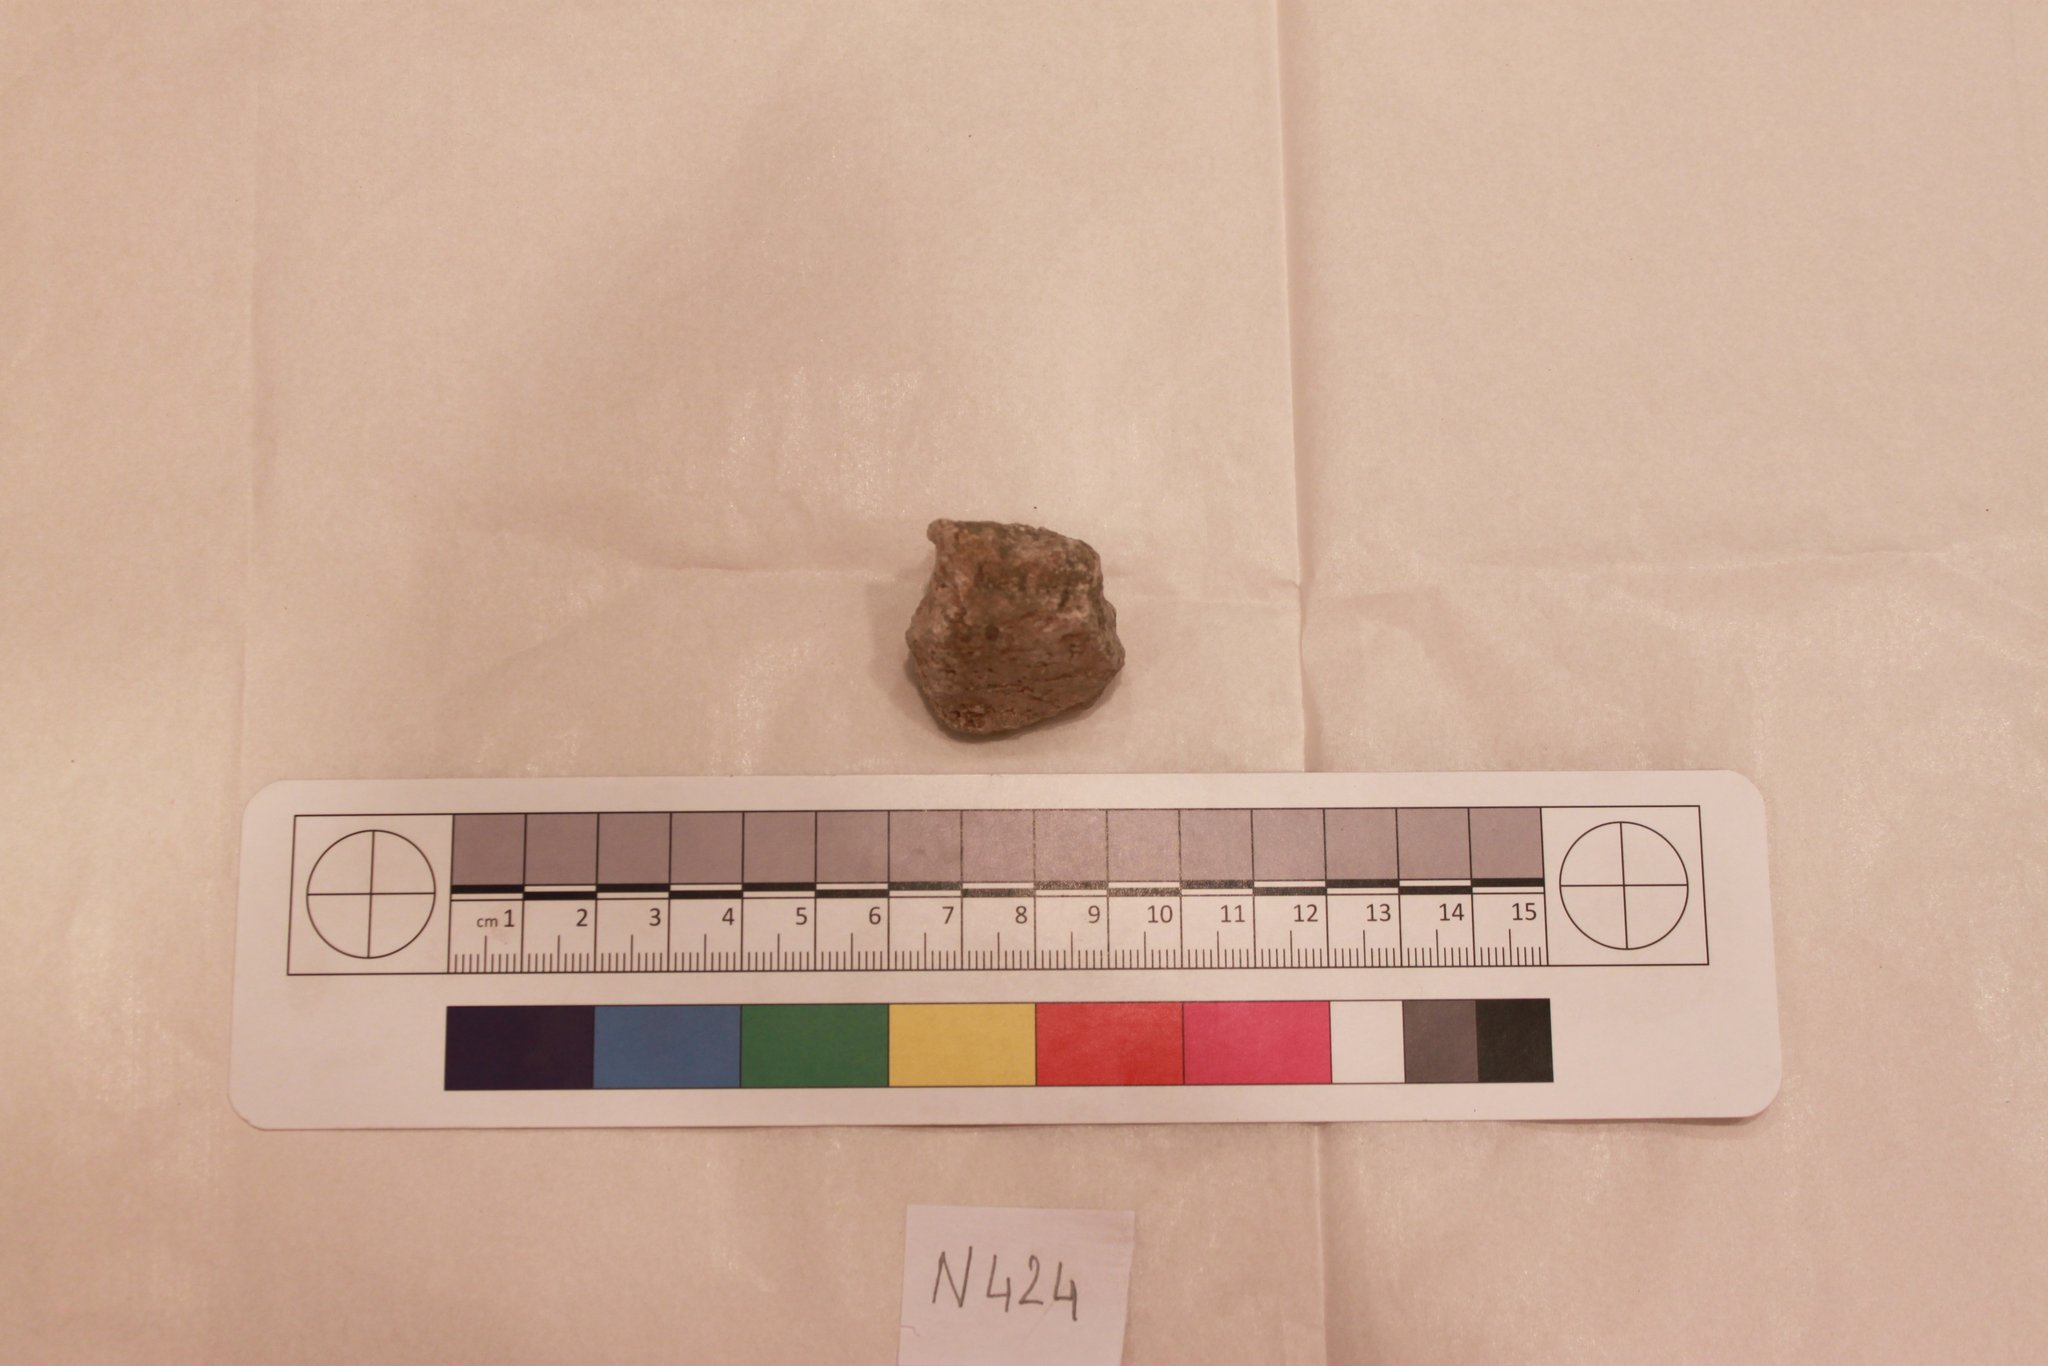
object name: fragment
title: Stucco Fragment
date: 701-1200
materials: plaster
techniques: carving, painting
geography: iran